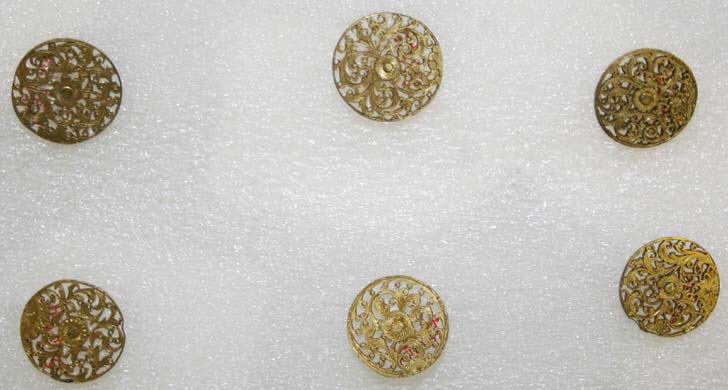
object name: button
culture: american or european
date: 1880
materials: metal